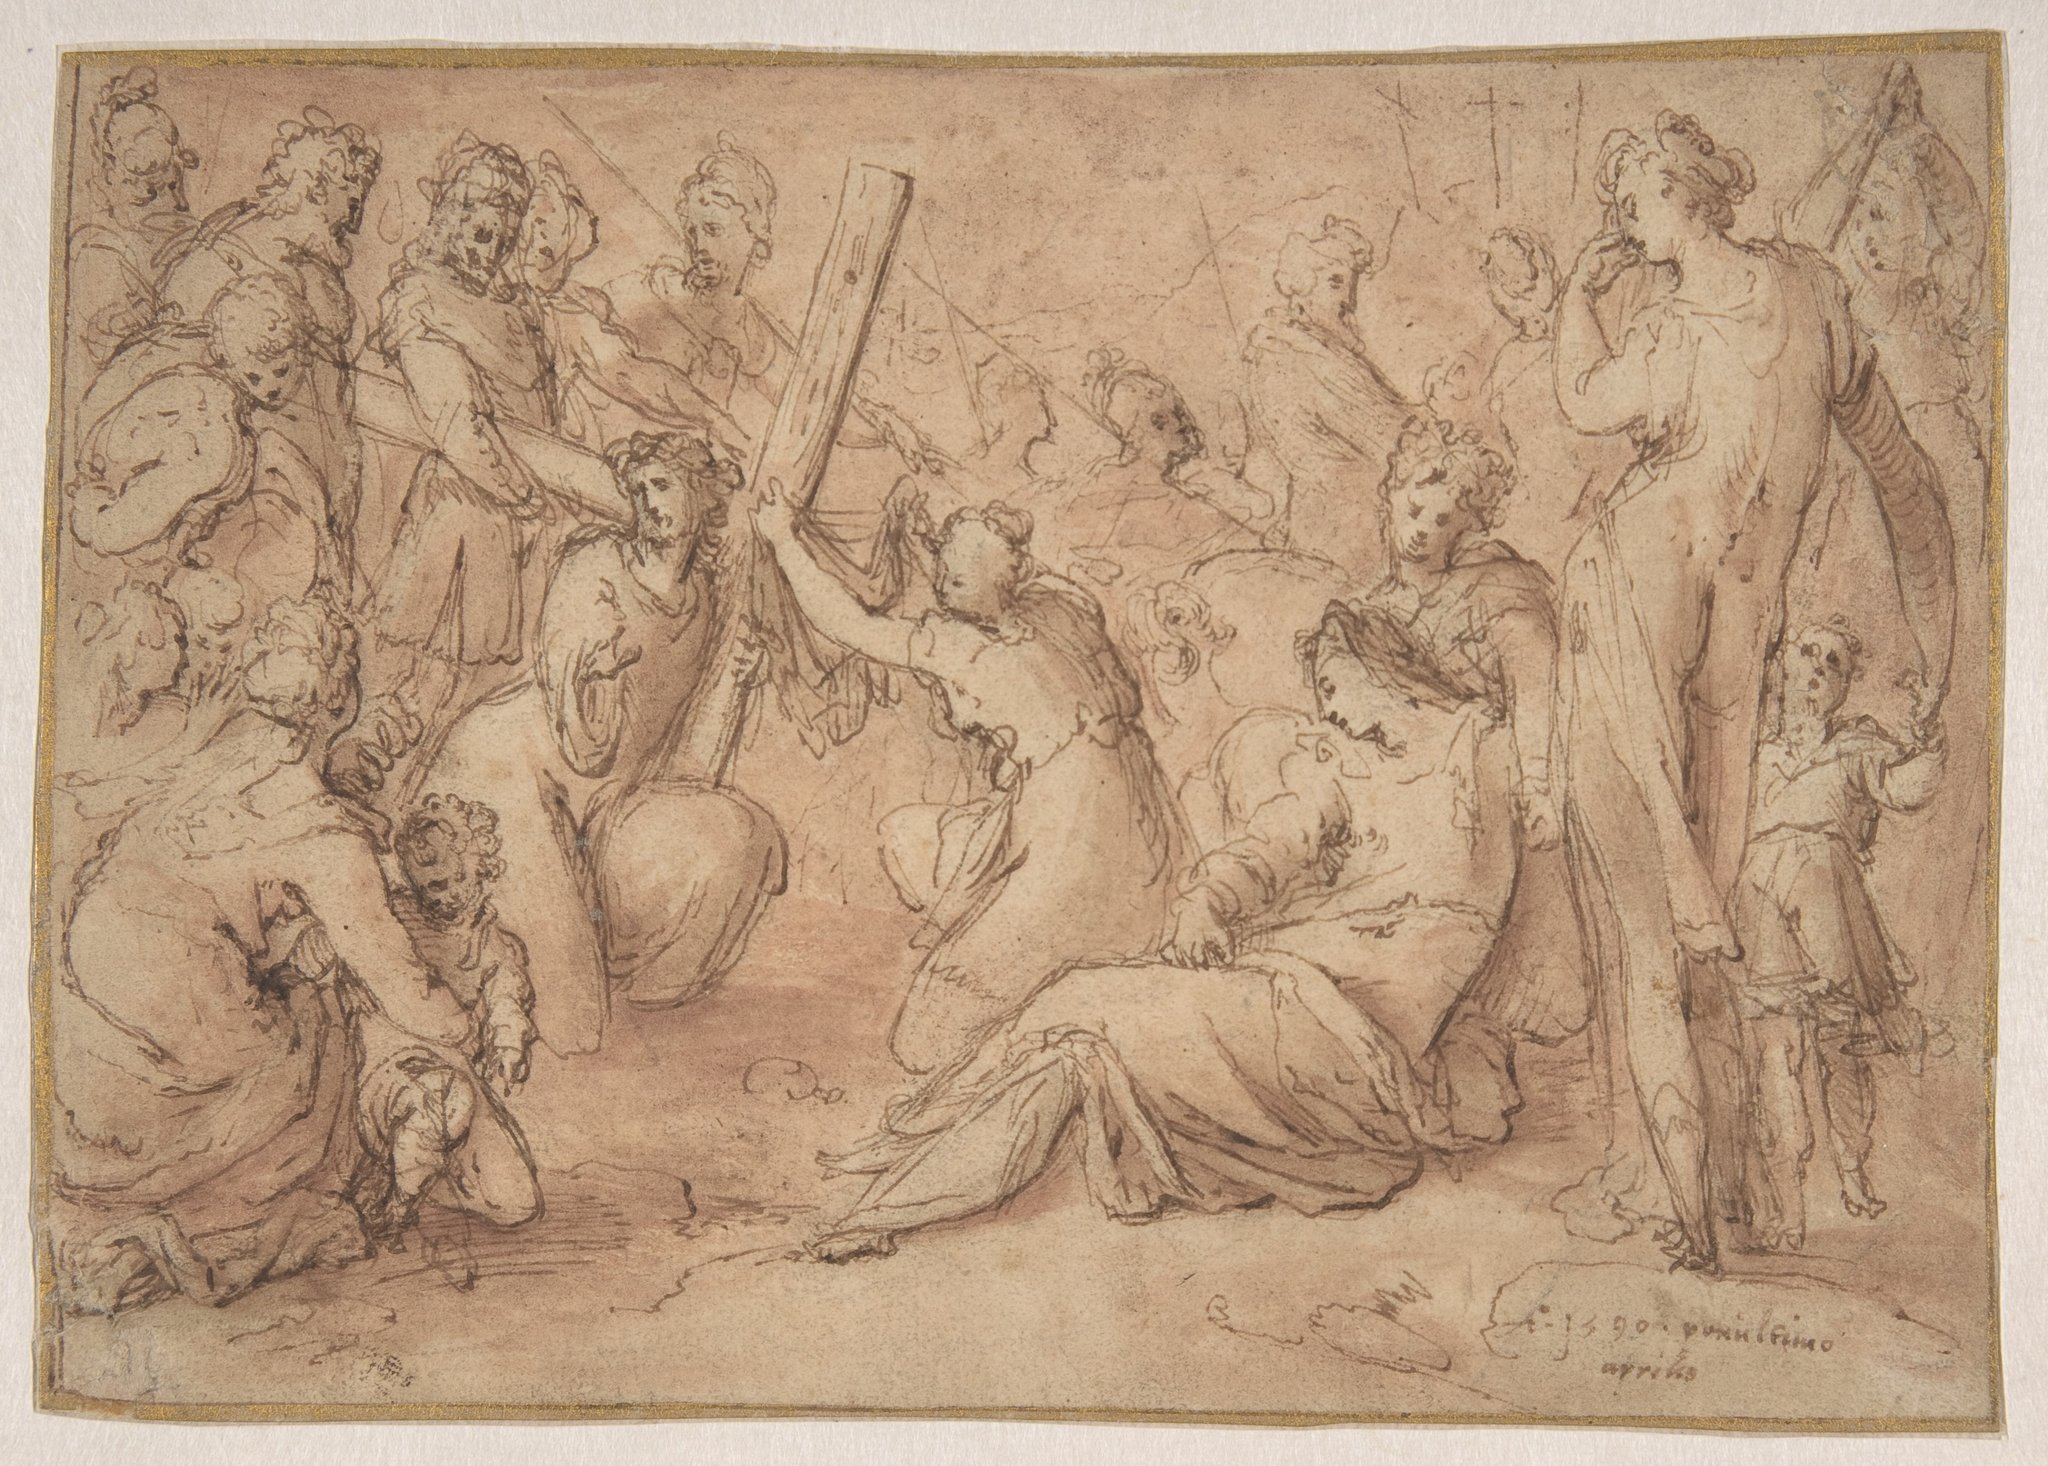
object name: drawing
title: Christ Carrying the Cross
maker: caspar fraisinger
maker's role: artist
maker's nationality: german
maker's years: 1560-1599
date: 1590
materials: gold, ink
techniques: brush, pen, wash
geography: germany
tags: infants,women,christ,cross